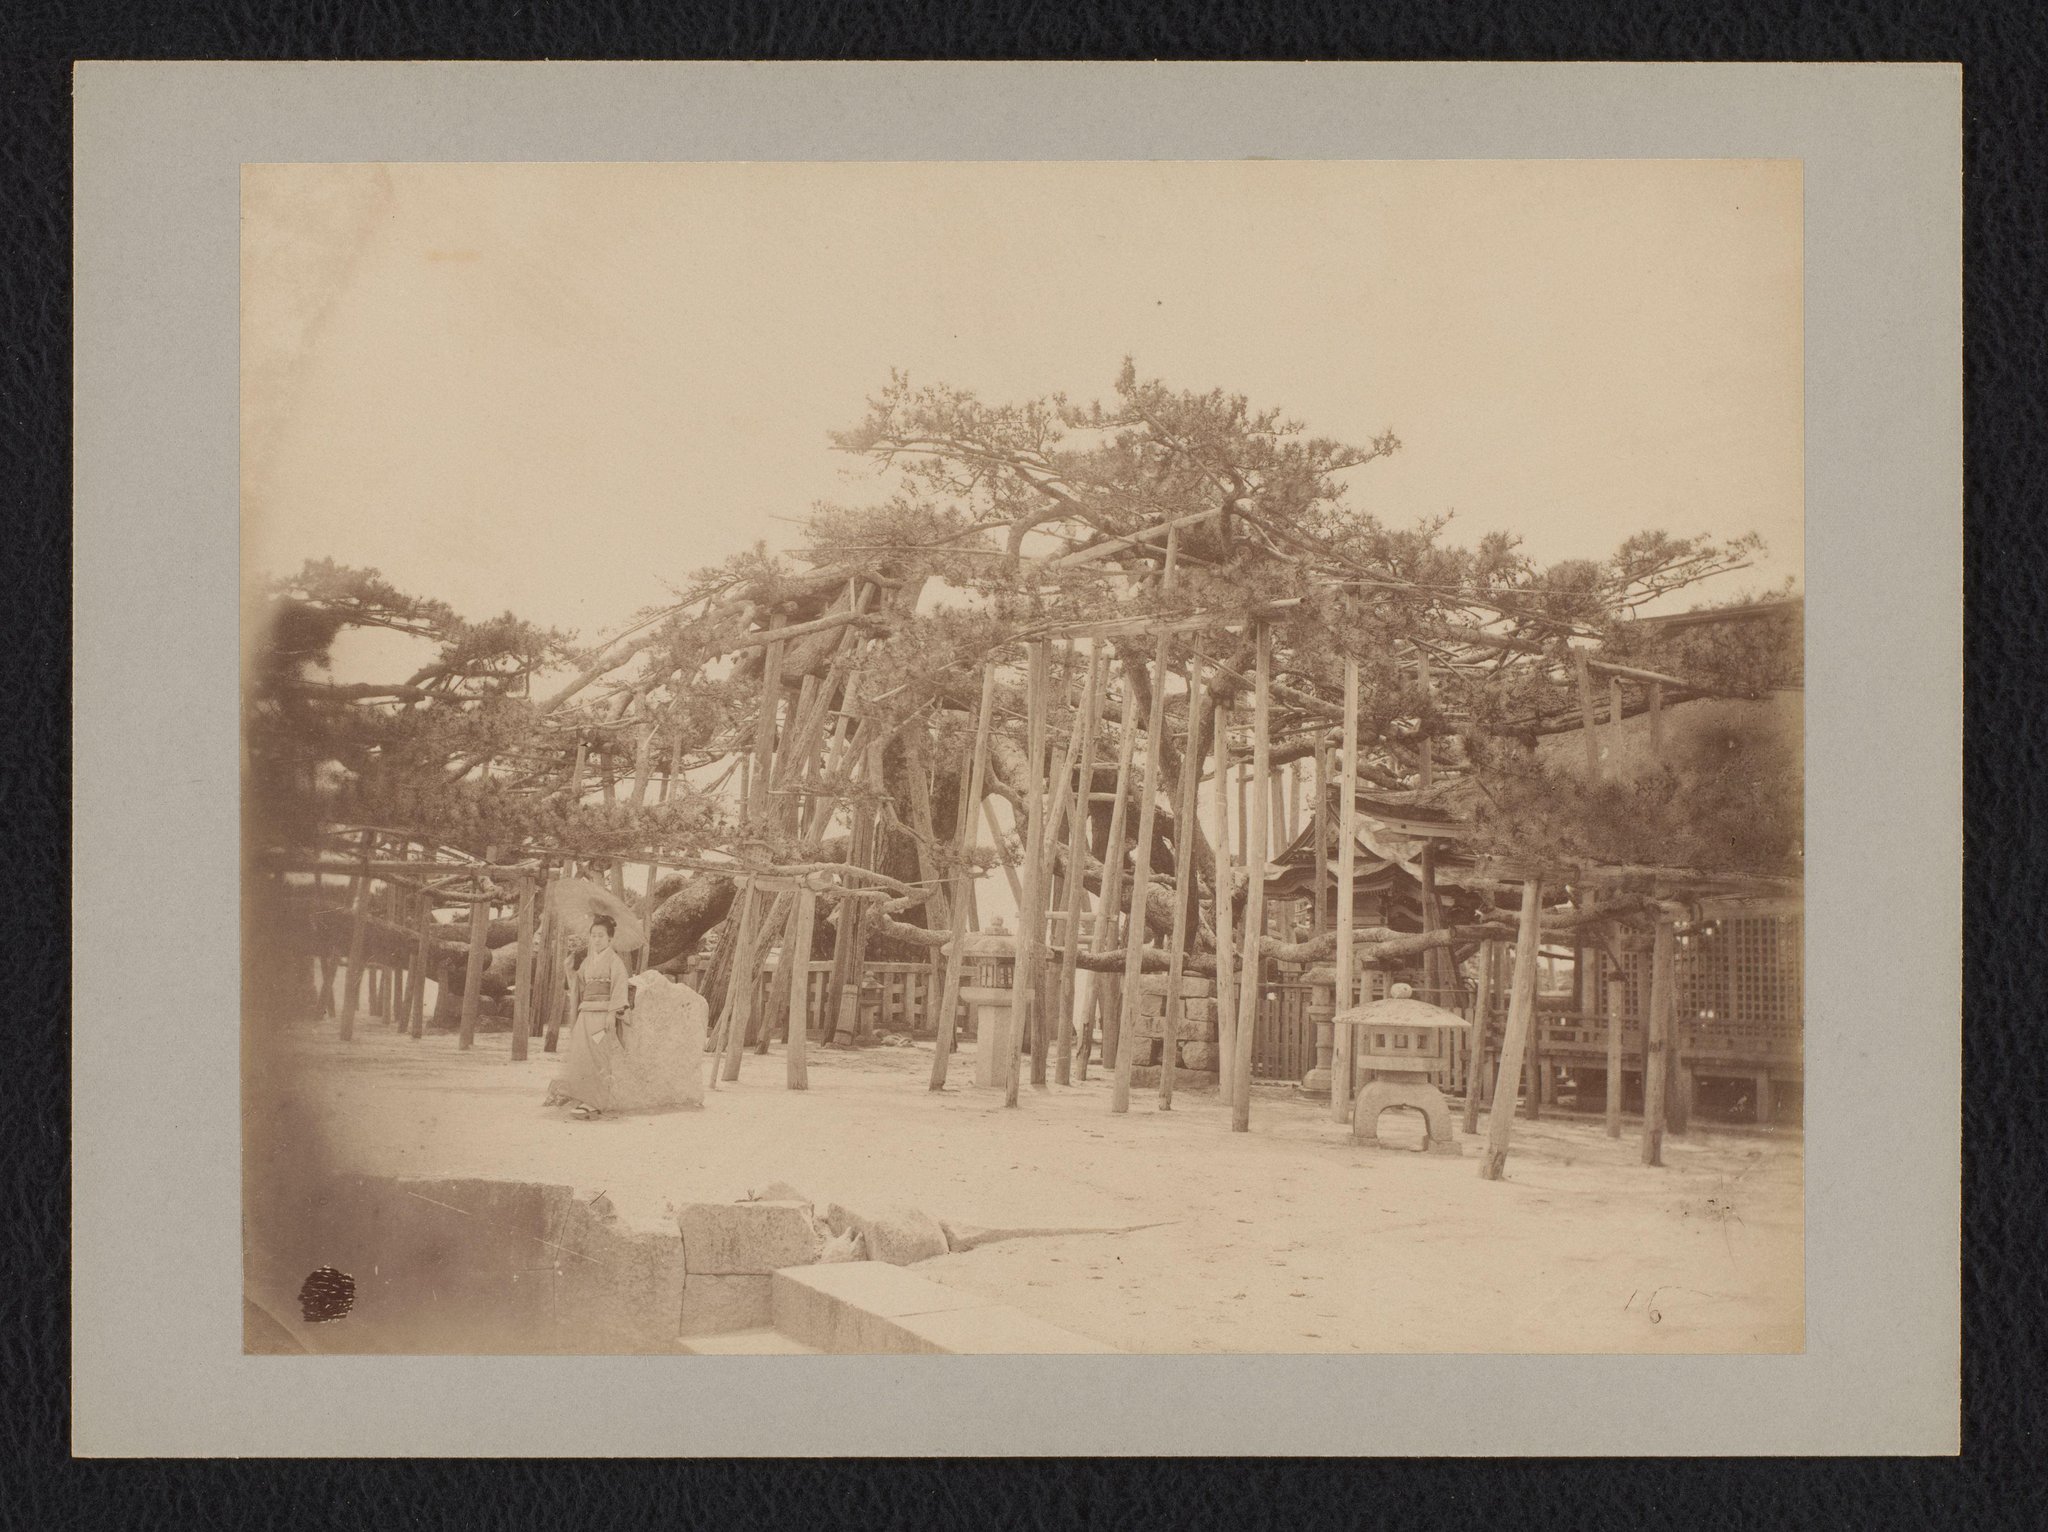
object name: photograph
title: Heilige boom bij Biwameer, Japan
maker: Anonymous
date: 1895-1915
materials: cardboard, photographic support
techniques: albumen print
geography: japan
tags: japan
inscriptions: number: ‘12. Heilige boom bij Biwa-meer.’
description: Heilige boom waarnaast links een Japanse vrouw staat met een parasol.